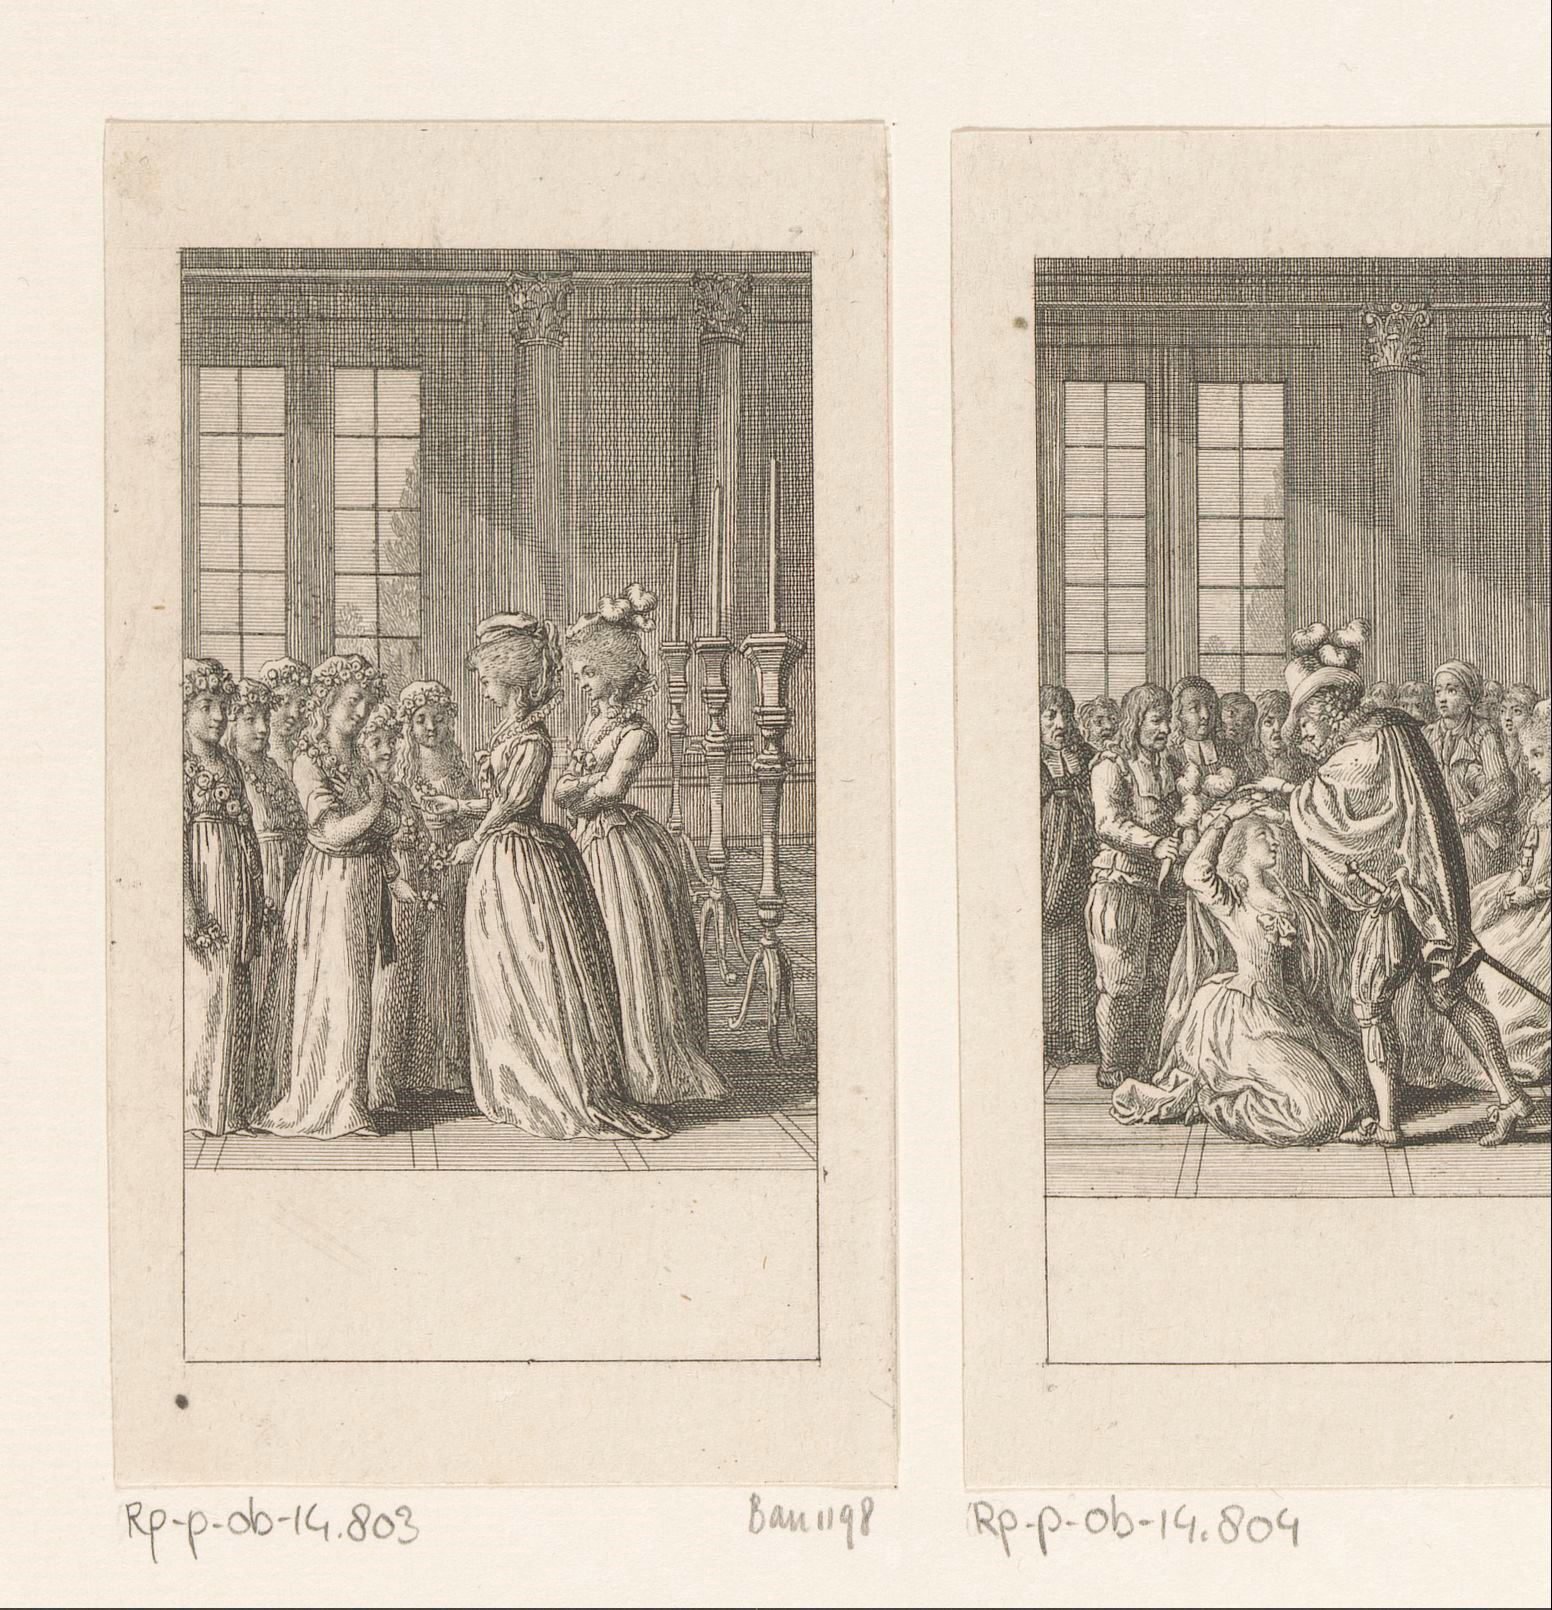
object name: print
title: Chérubim staat verkleed als meisje voor Suzanne en de gravin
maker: daniel nikolaus chodowiecki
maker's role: draughtsman, print maker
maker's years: 1726-1801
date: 1785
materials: paper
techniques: etching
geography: berlin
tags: paris, publisher, adolescent, young woman, maiden, man dressed as woman, travesty, literature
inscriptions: collector's mark: Lugt 2228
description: Vervaardigd voor 'le Mariage de Figaro' van Pierre Augustin Caron de Beaumarchais. Latere staat gebruikt voor: Almanac de Gotha contenant diverses connoissances curieuses et utiles pour l'année (...). Gotha: C. W. Ettinger, 1785.